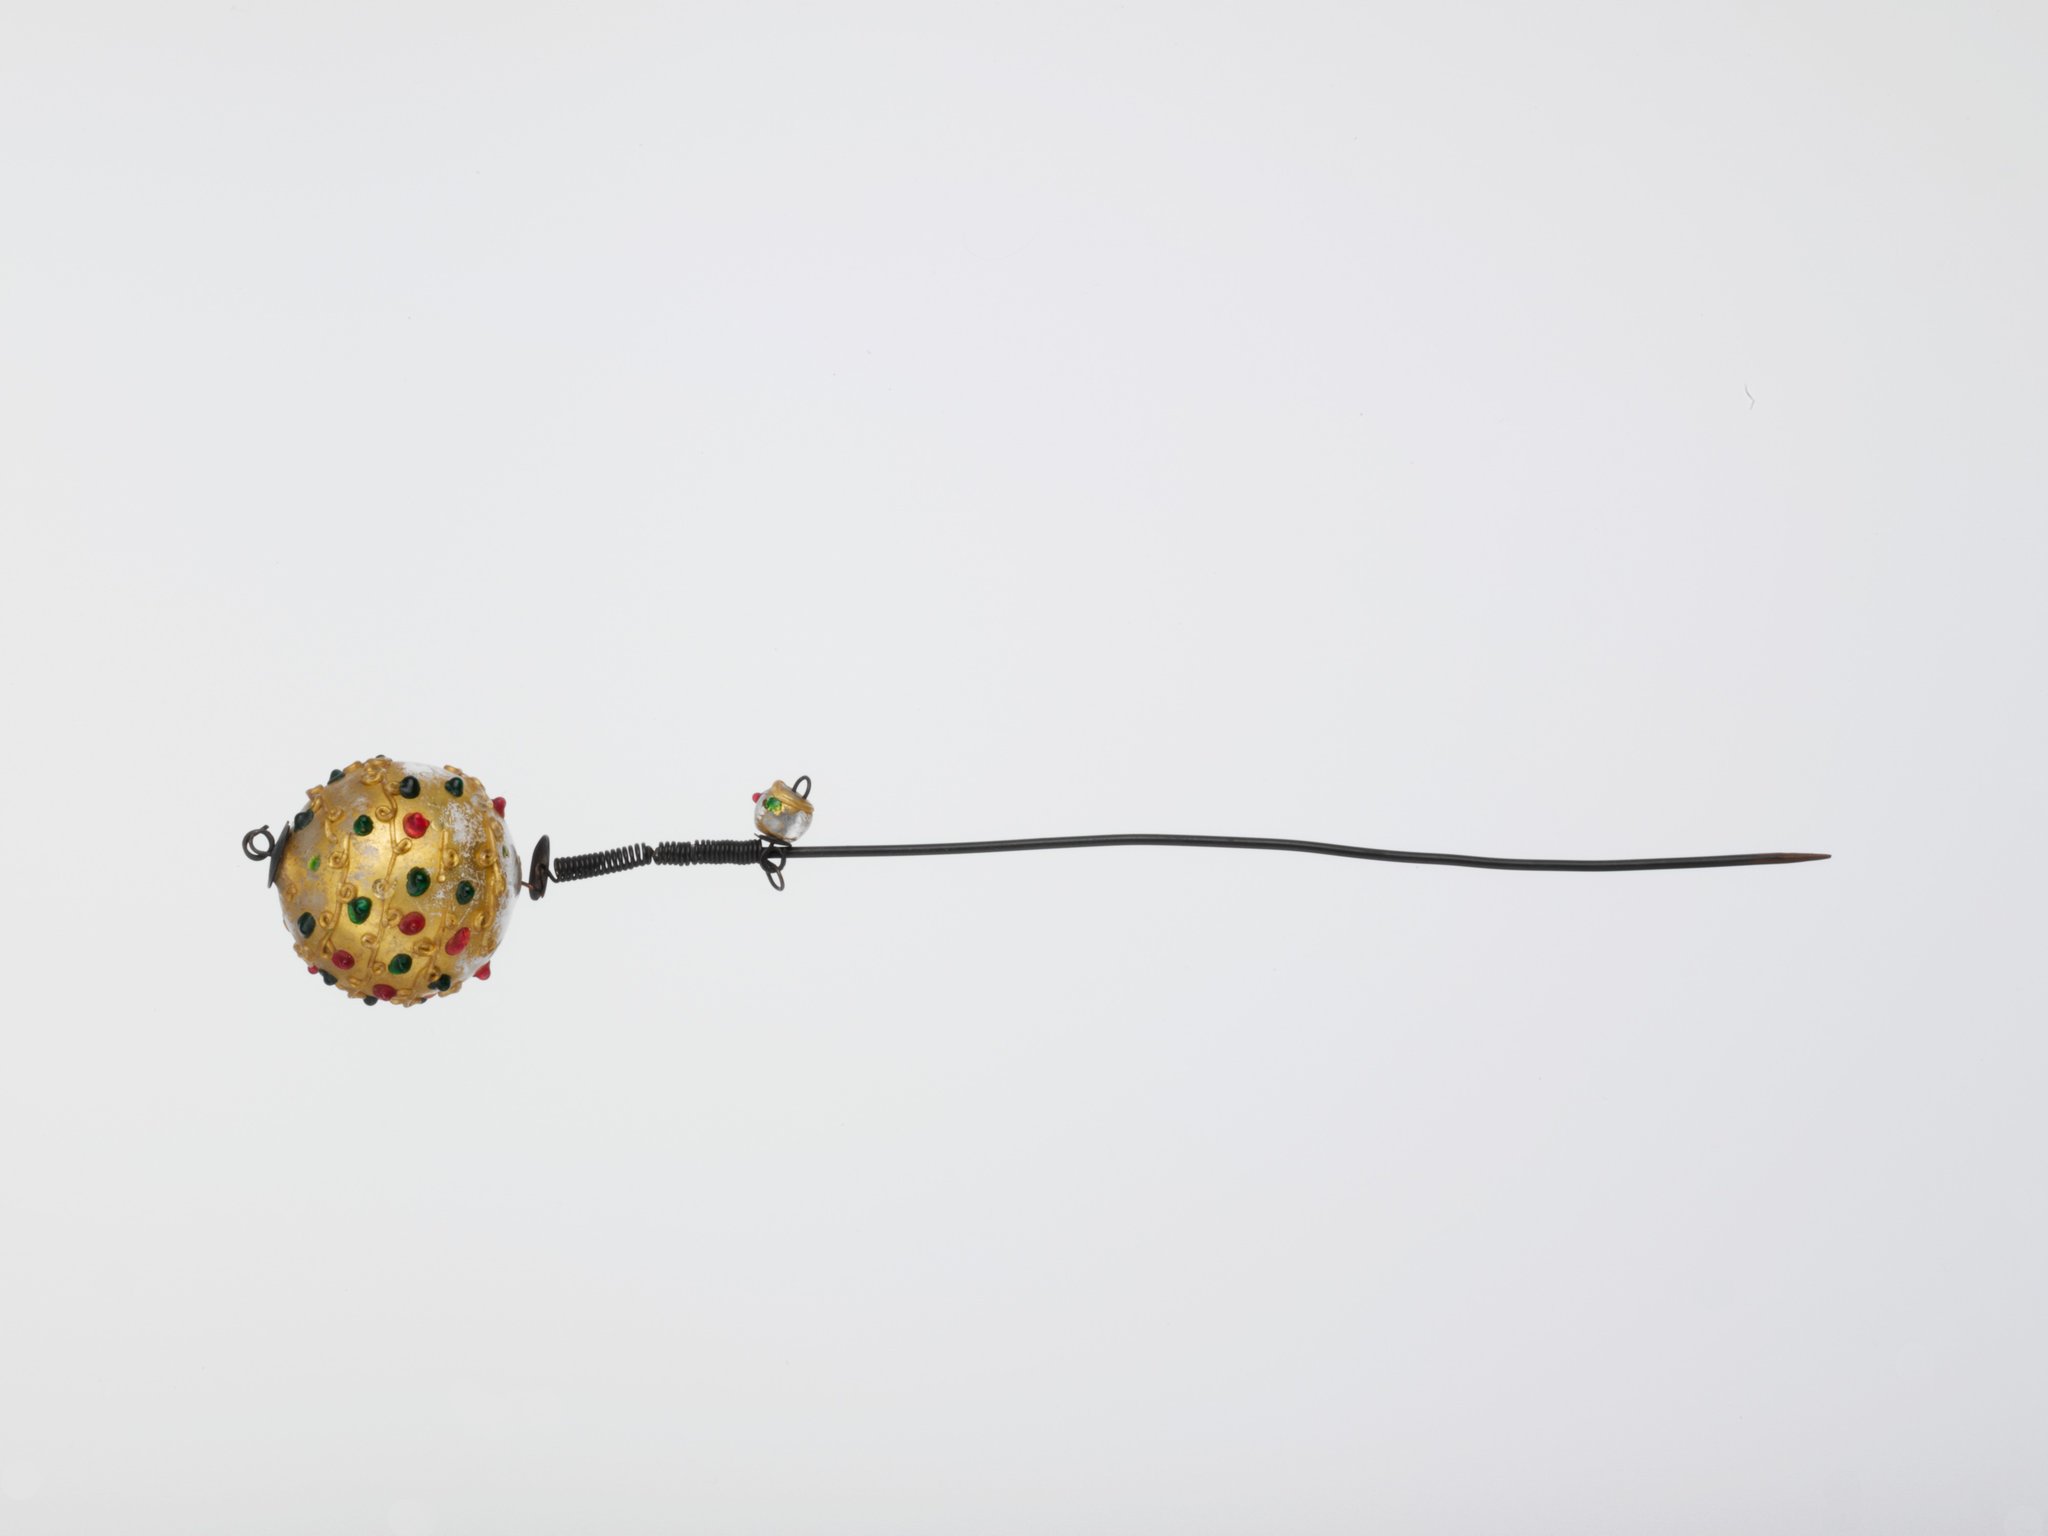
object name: hairpin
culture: italian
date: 1801-1900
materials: copper, gilt, glass, metal